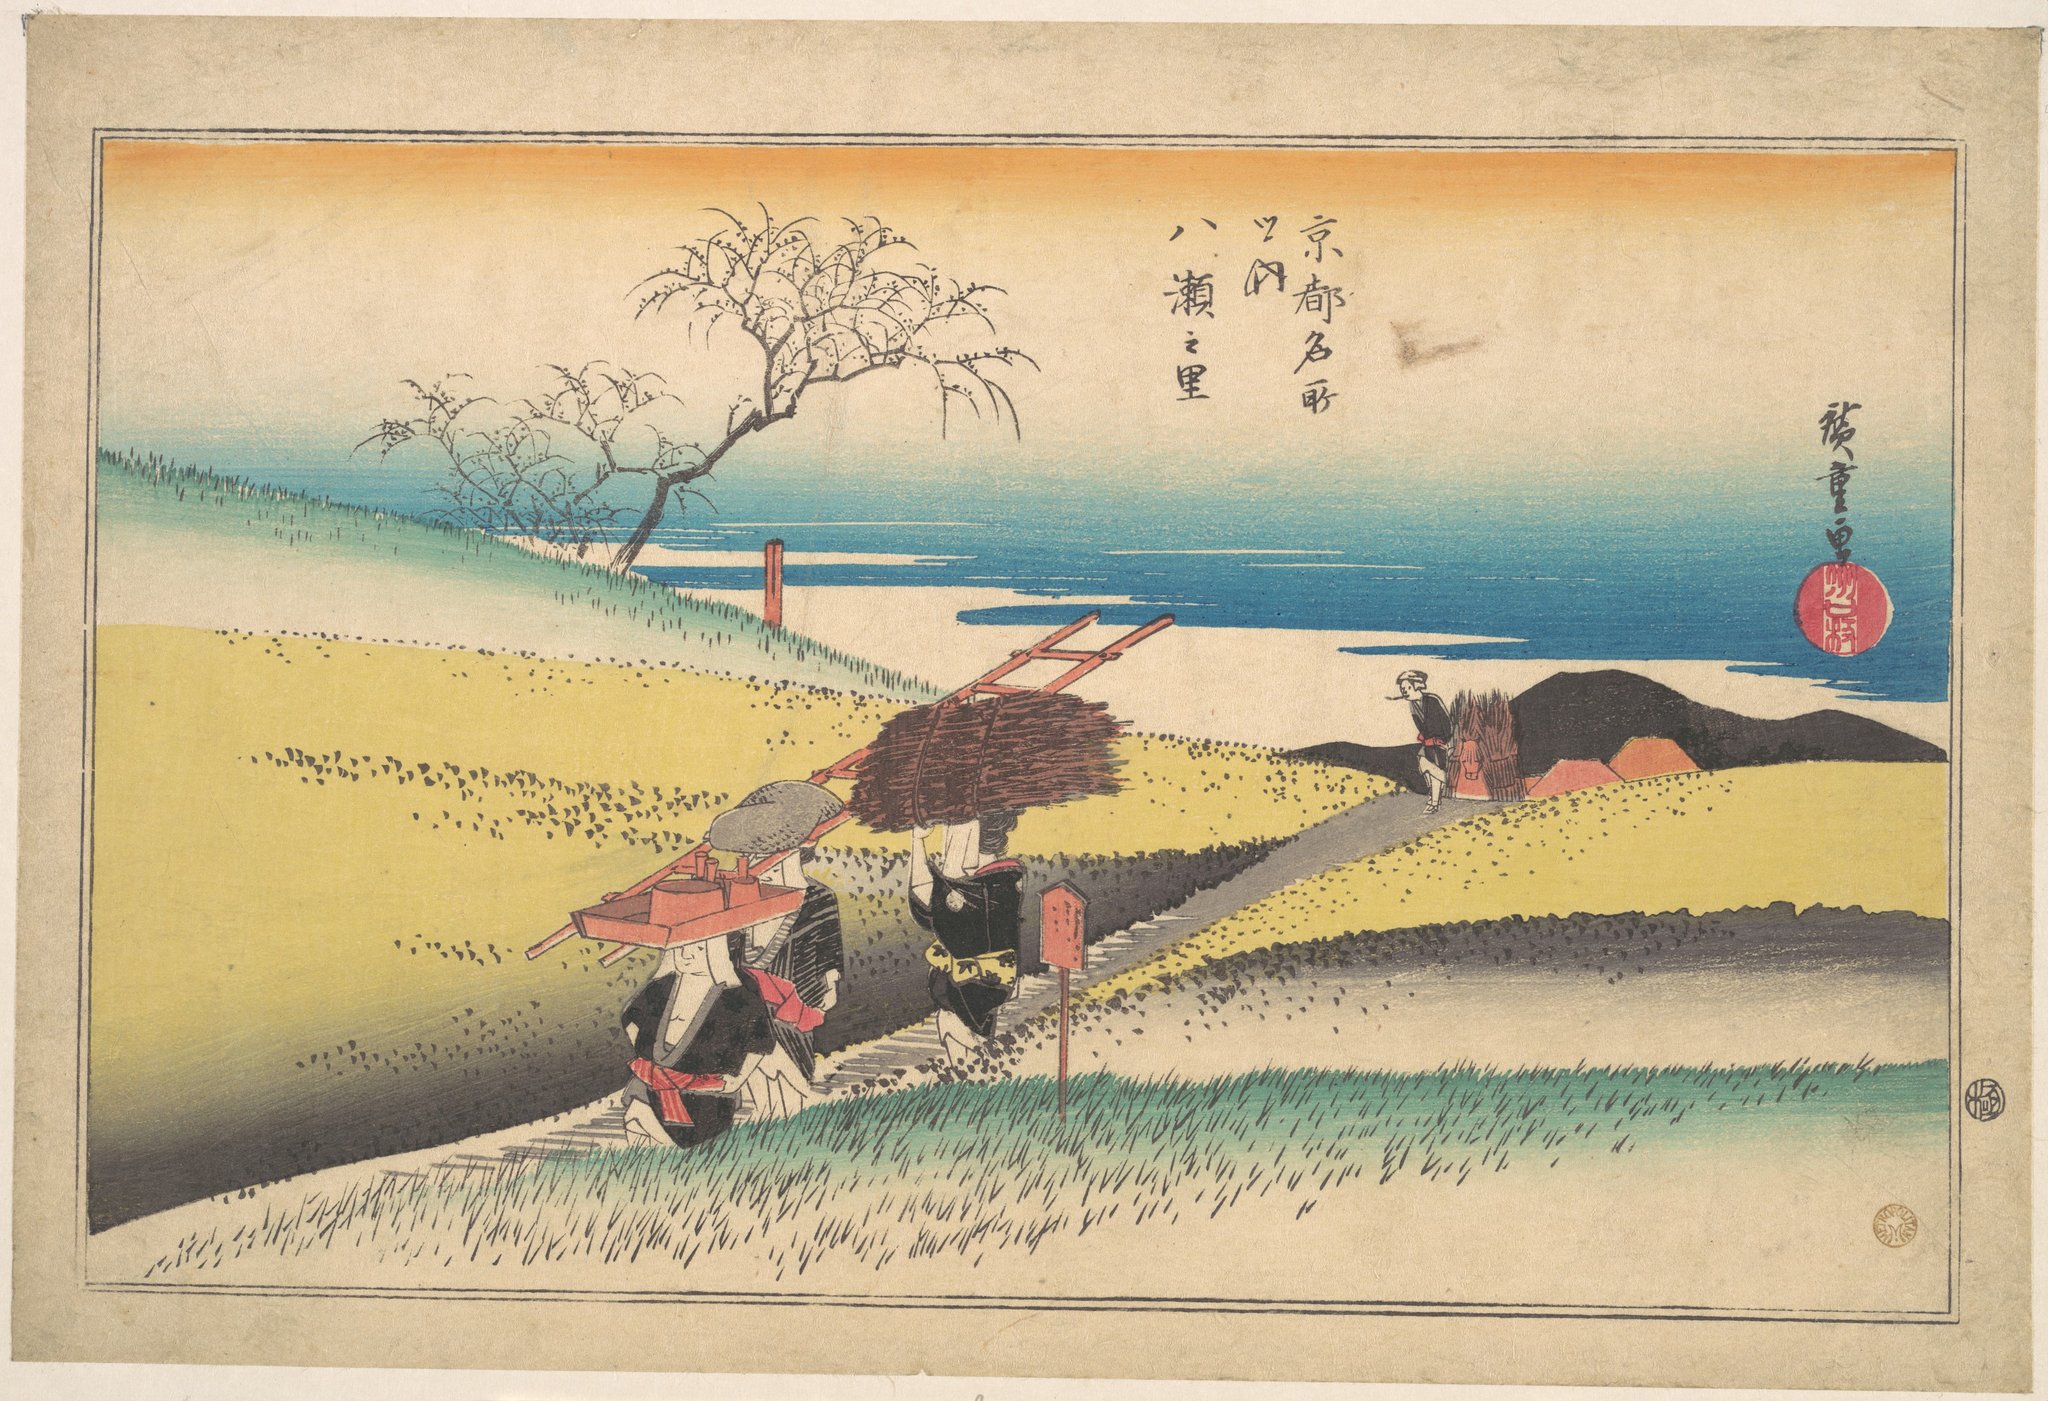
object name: print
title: Yase no Sato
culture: japanese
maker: utagawa hiroshige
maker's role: artist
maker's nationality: japanese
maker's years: 1797-1858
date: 1834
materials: ink, paper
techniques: woodblock print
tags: men,landscapes